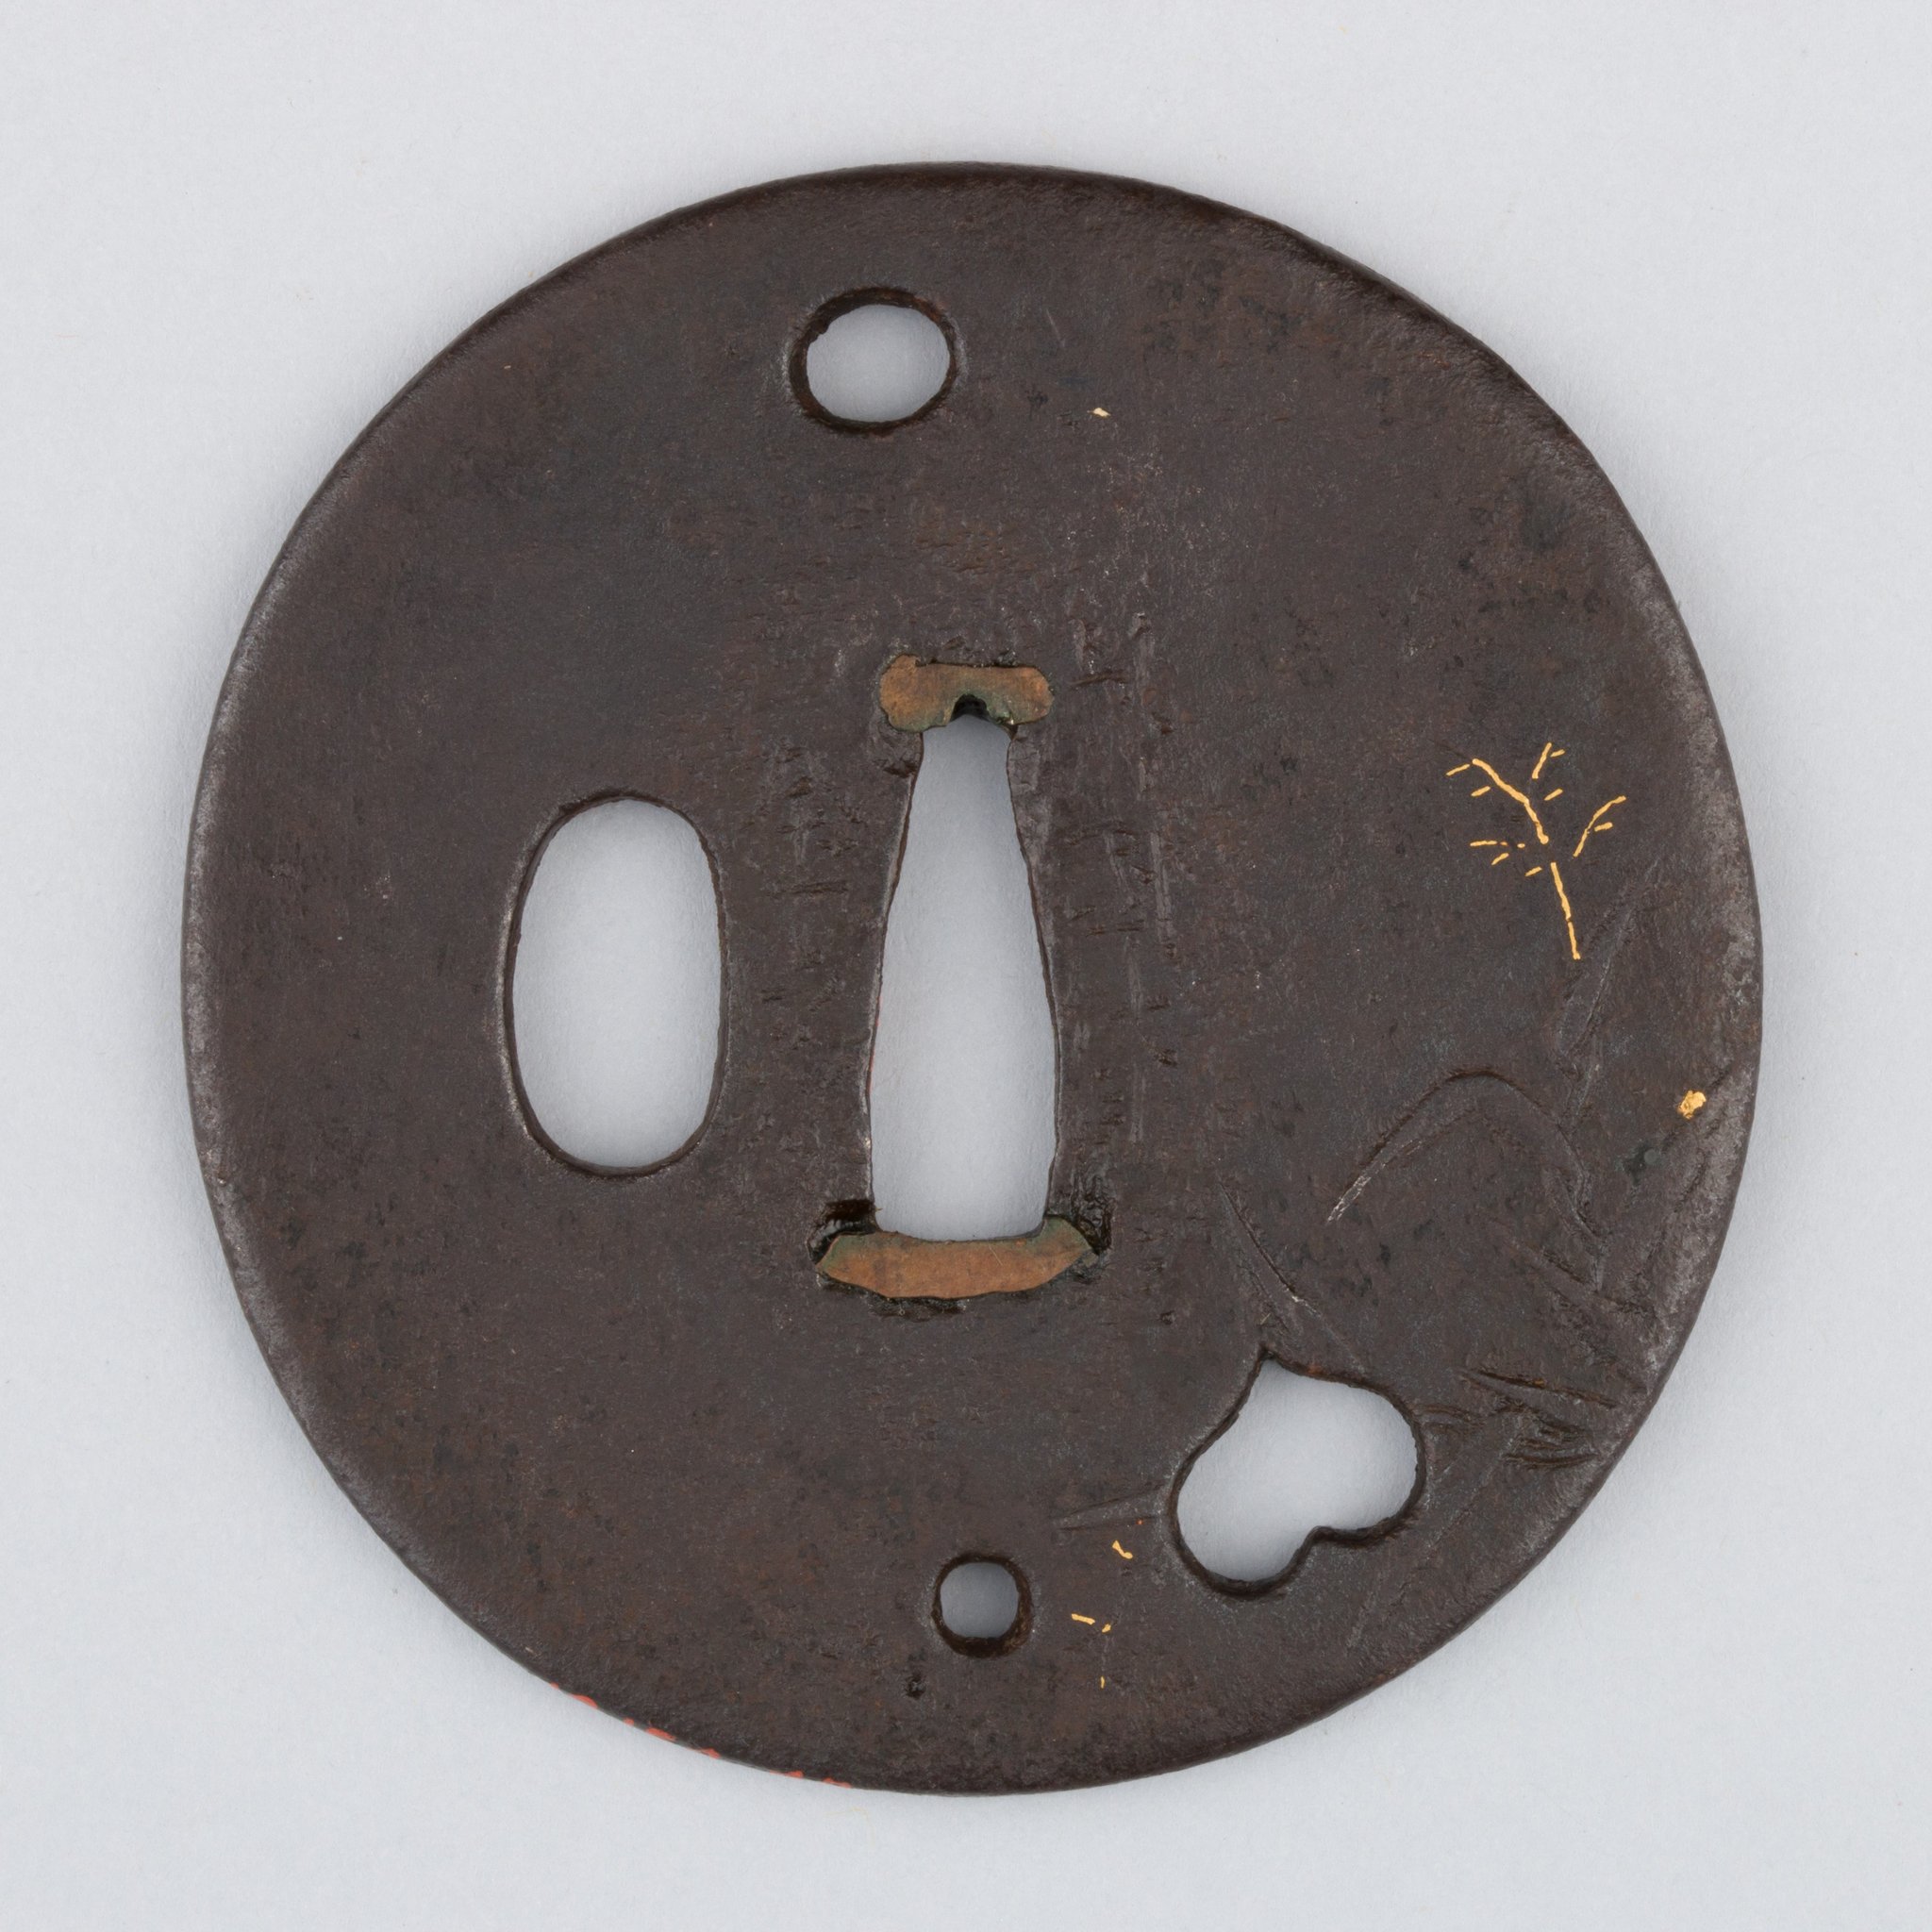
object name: sword guard tsuba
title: Sword Guard (Tsuba)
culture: japanese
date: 1615-1868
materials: copper, iron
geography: japan